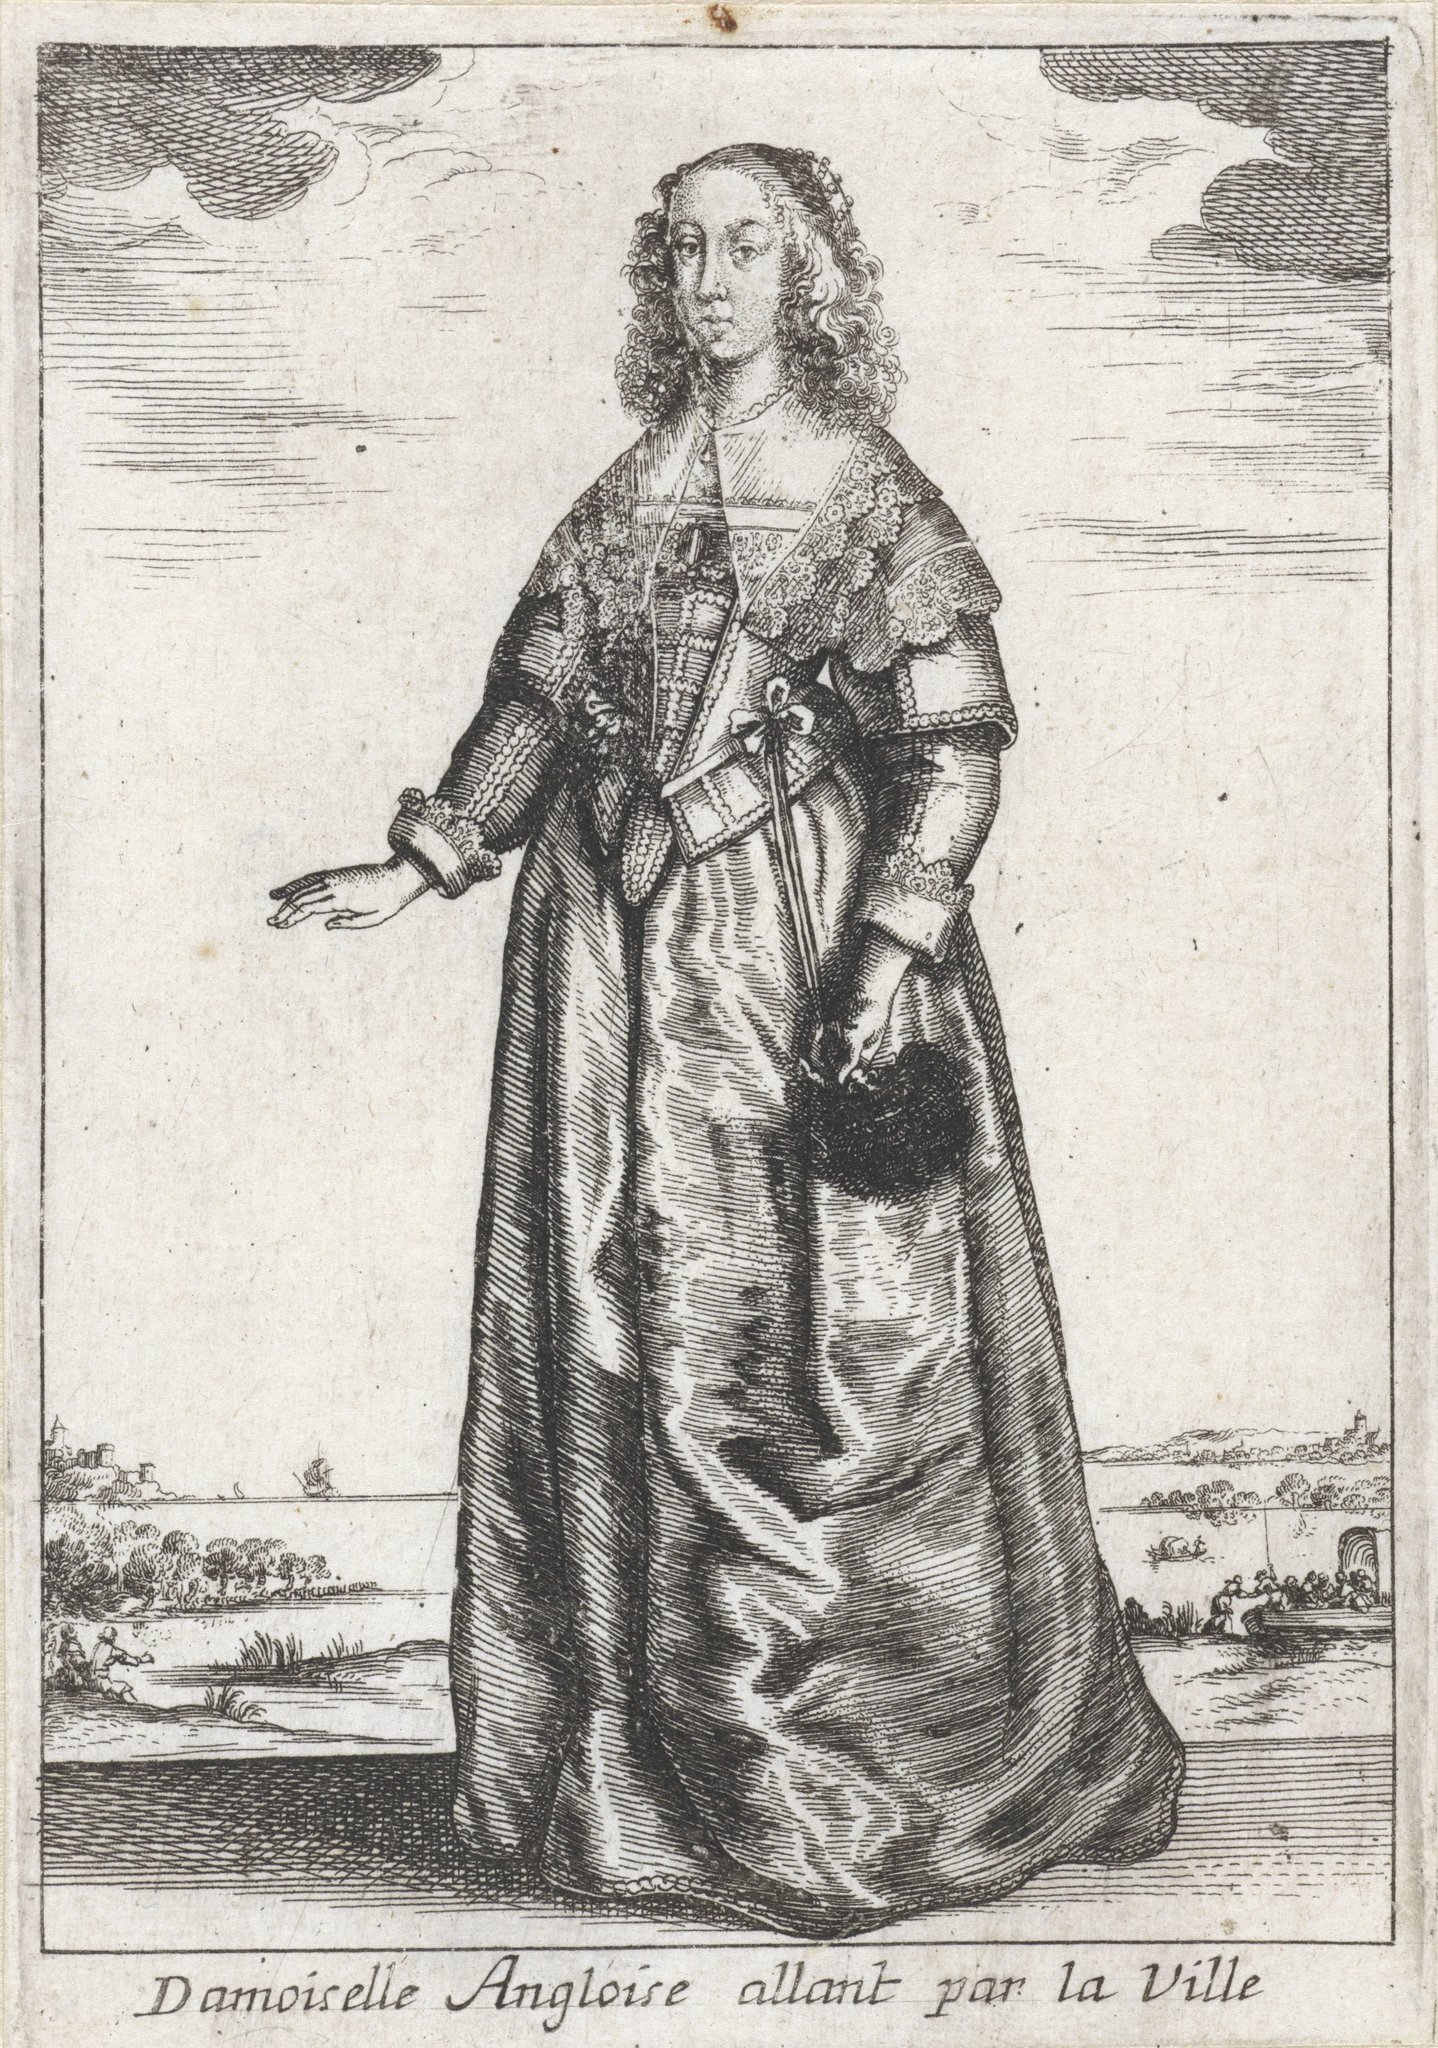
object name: costume print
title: Damoiselle Angloise allant par la Ville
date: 1662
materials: paper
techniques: etching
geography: paris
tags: neck-gear ~ clothing (neckerchief) (+ women's clothes), neck-gear: collar (+ women's clothes), fashion plates, skirt (+ women's clothes), sleeves: cuffs (+ women's clothes), dress, gown (+ women's clothes), sleeves (+ women's clothes), clothing for the upper part of the body (with name) (+ women's clothes), england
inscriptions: collector's mark: Lugt 240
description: Kopie naar prent die deel uitmaakt van de 50-delige serie met Europese klederdrachten, getiteld "Aula Veneris".. De prent maakt deel uit van de 28-delige serie (excl. titelprent) met voorstellingen van vrouwen in verschillende klederdrachten, getiteld "Livre curieux contenant la naifue representations des habits des femmes des diverses parties du Monde (...), 1662".